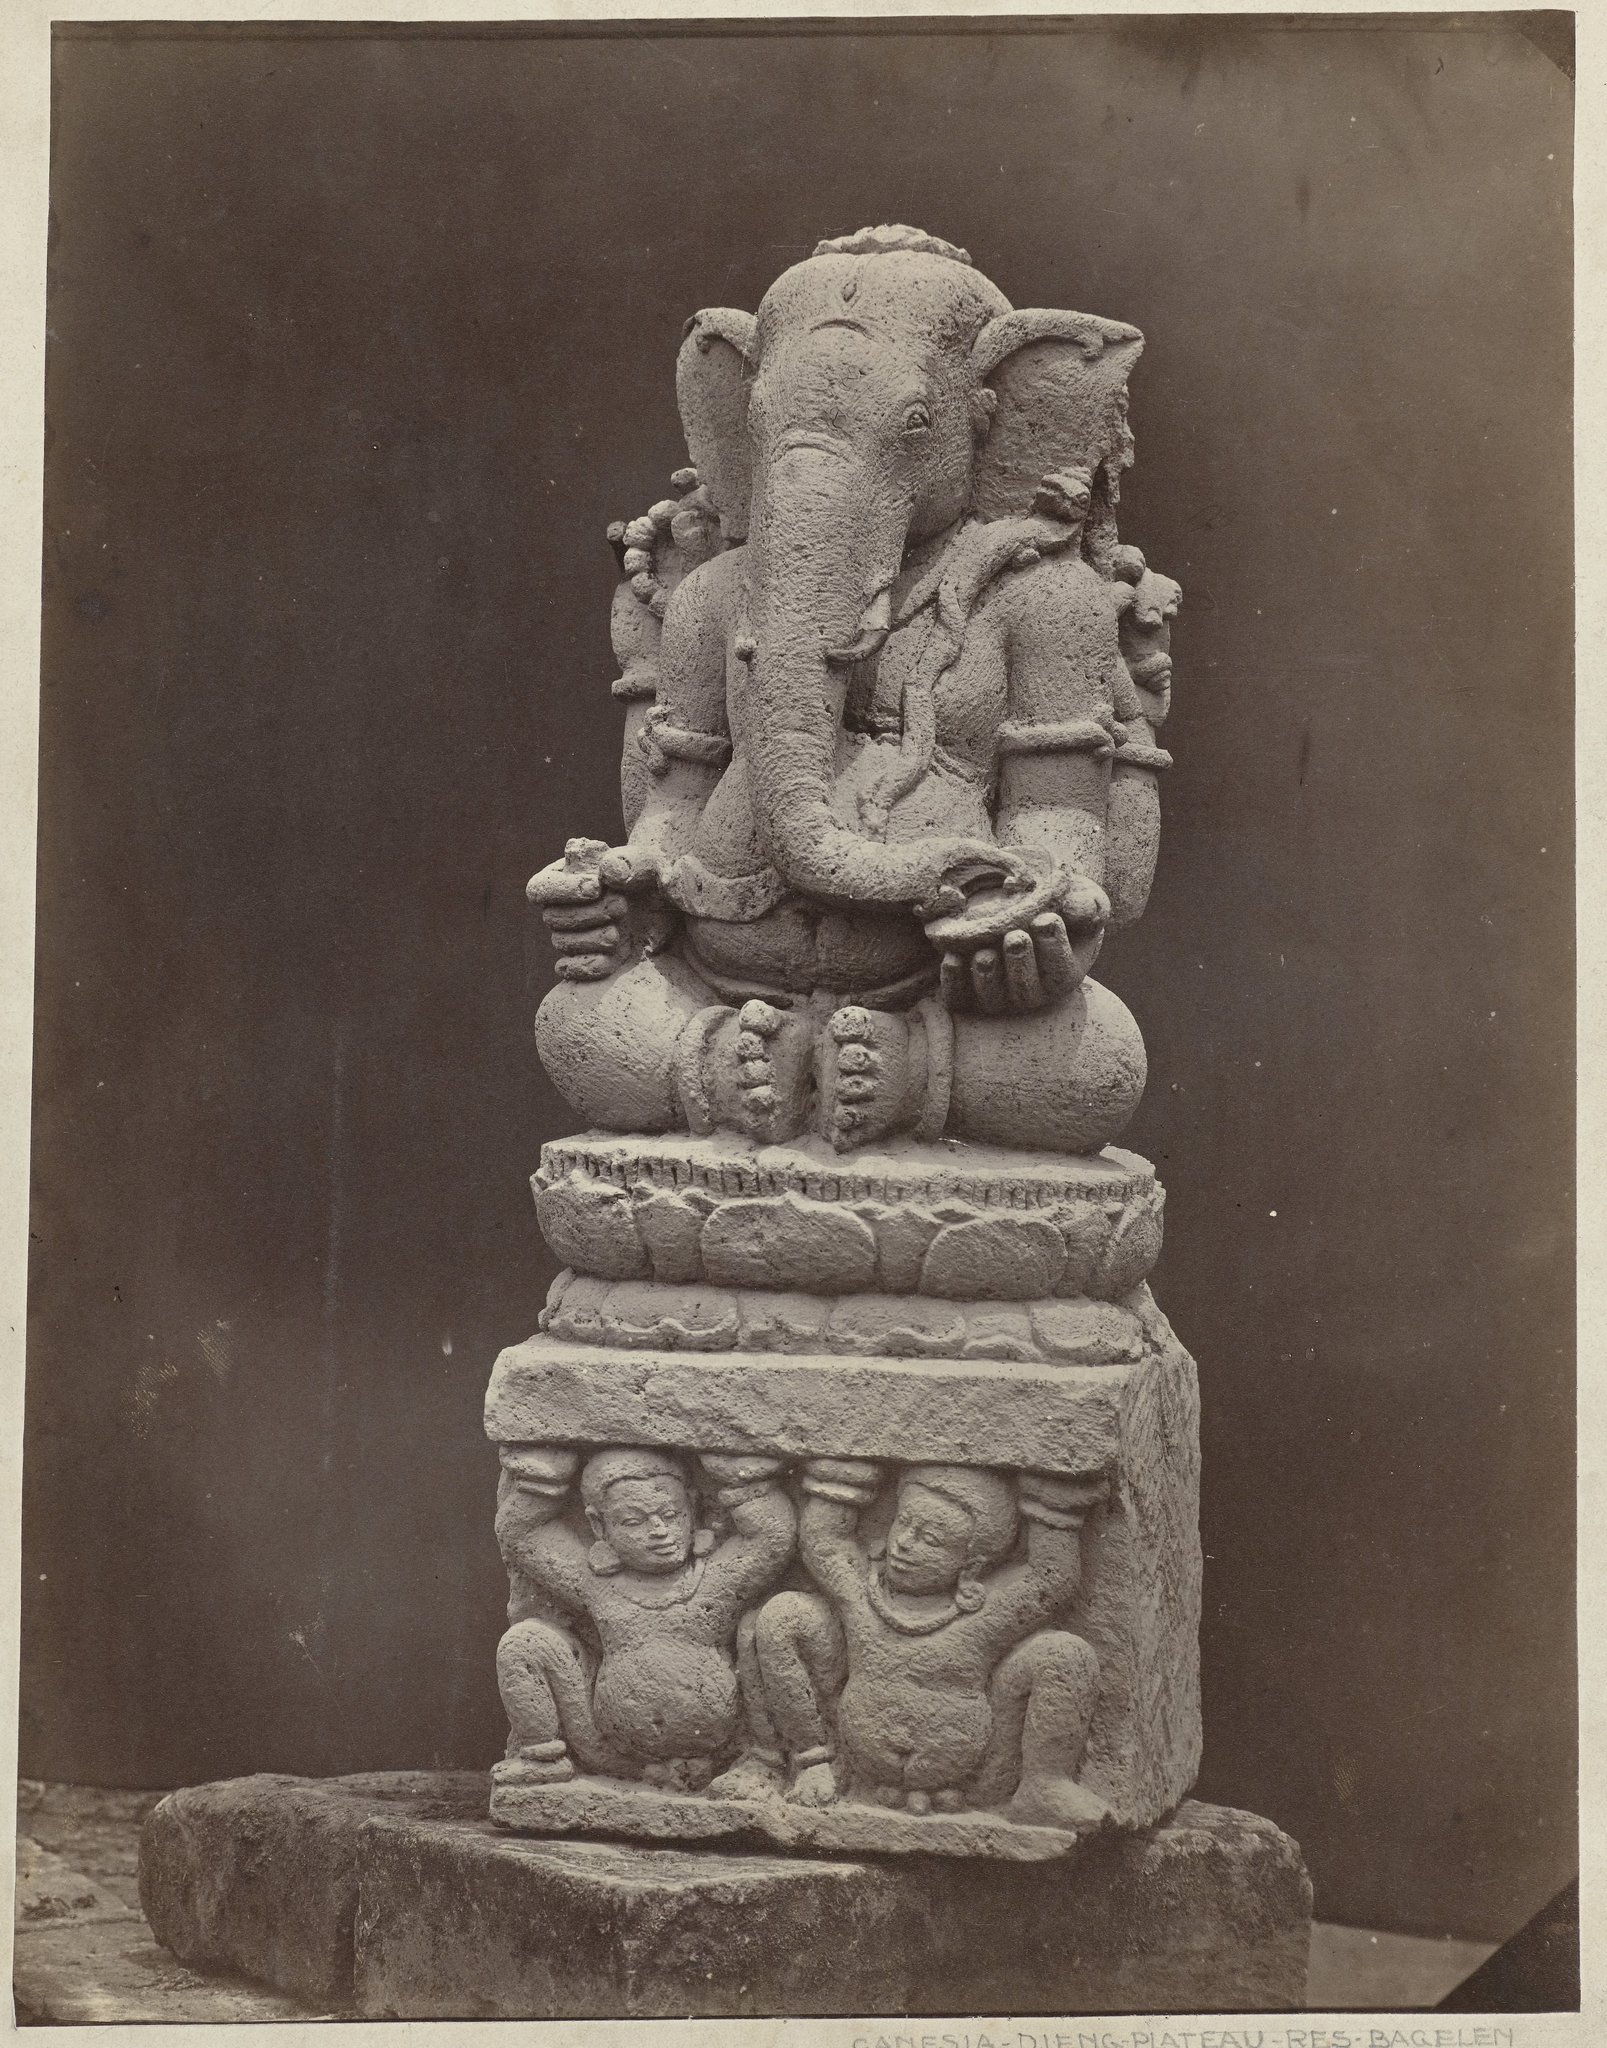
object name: photograph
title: Four armed Ganesha with a pedestal, decorated with two supporting gana figures. Dieng Plateau, Wonosobo district, Central Java province, 10th century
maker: isidore kinsbergen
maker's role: fotograaf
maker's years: 1821-1905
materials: cardboard, paper, photographic support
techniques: albumen print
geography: java